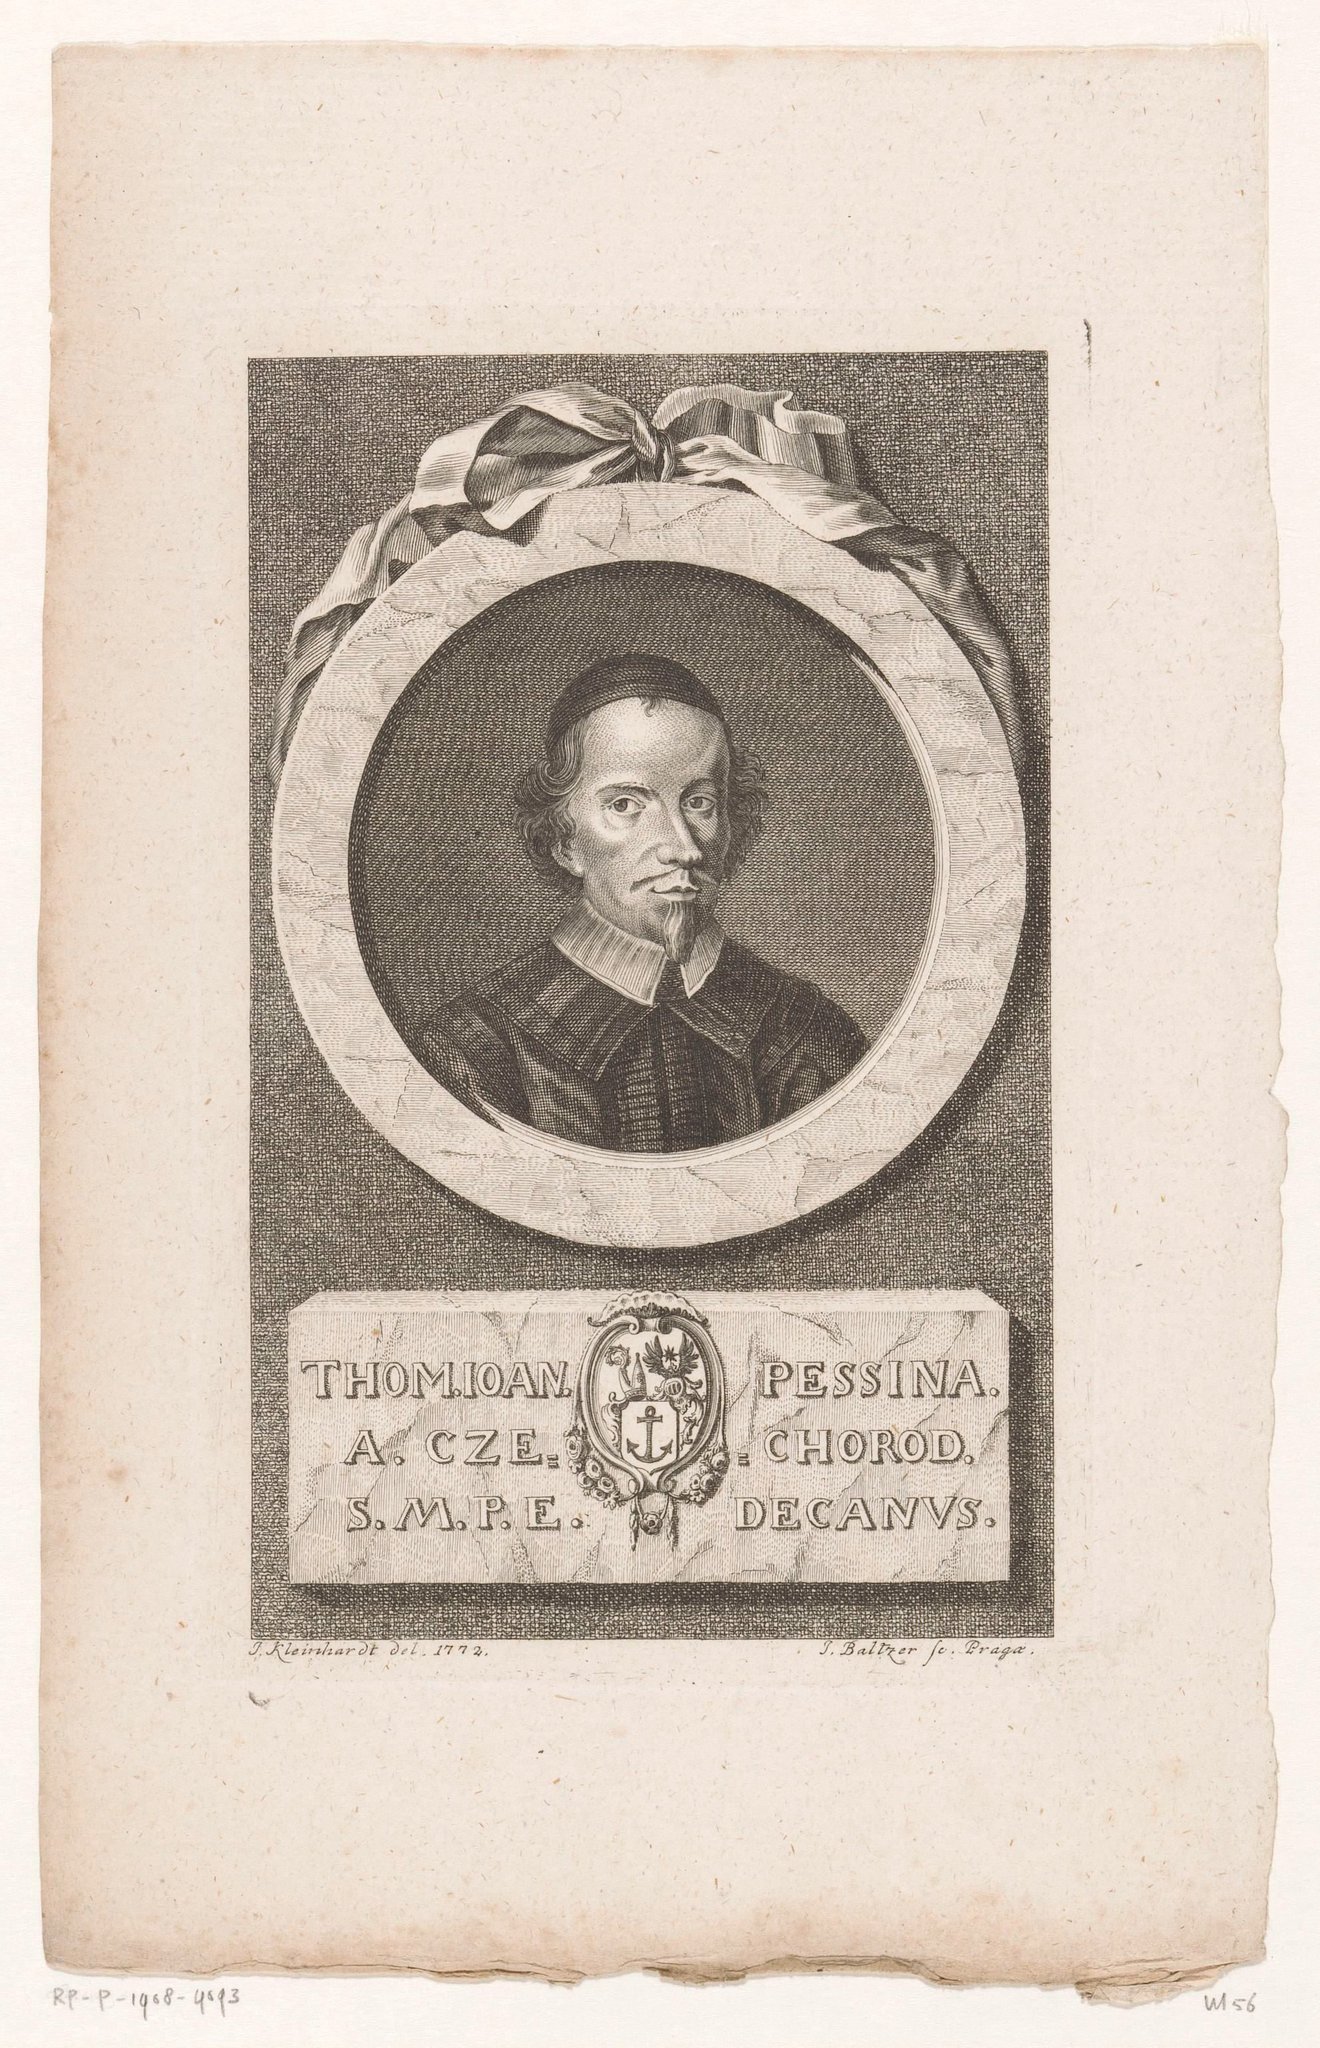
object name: print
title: Thom. Ioan. Pessina (...)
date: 1772-1799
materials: paper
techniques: engraving, etching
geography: prague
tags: historical persons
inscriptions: collector's mark: Lugt 2228